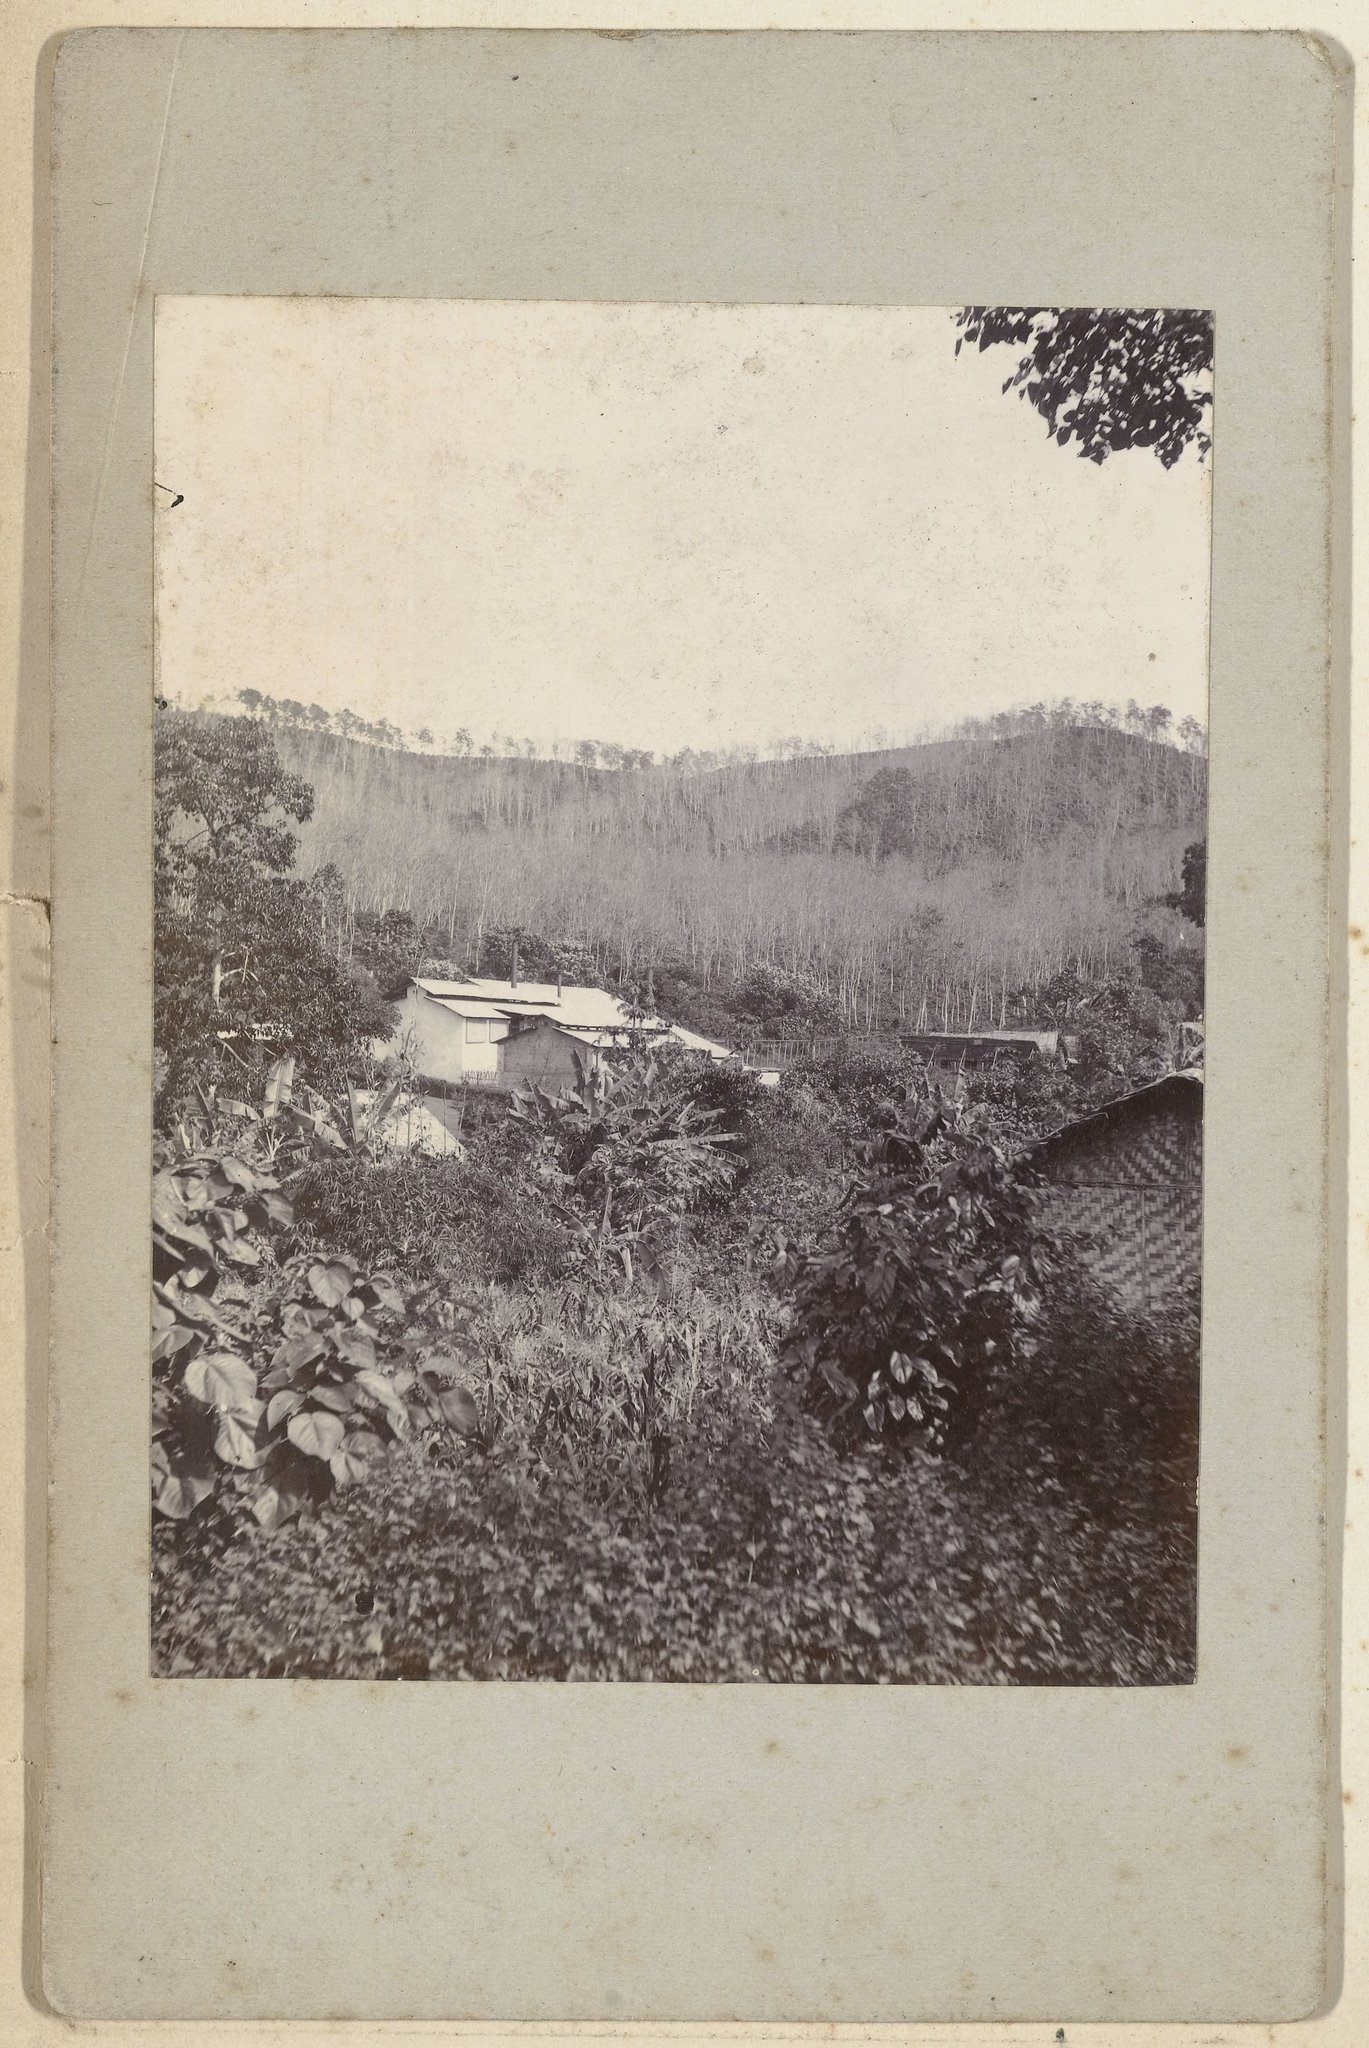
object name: photograph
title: Gevlochten hutjes in een boslandschap op Indonesië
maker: Anonymous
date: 1890-1910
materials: cardboard, paper, photographic support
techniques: gelatin silver print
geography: indonesia